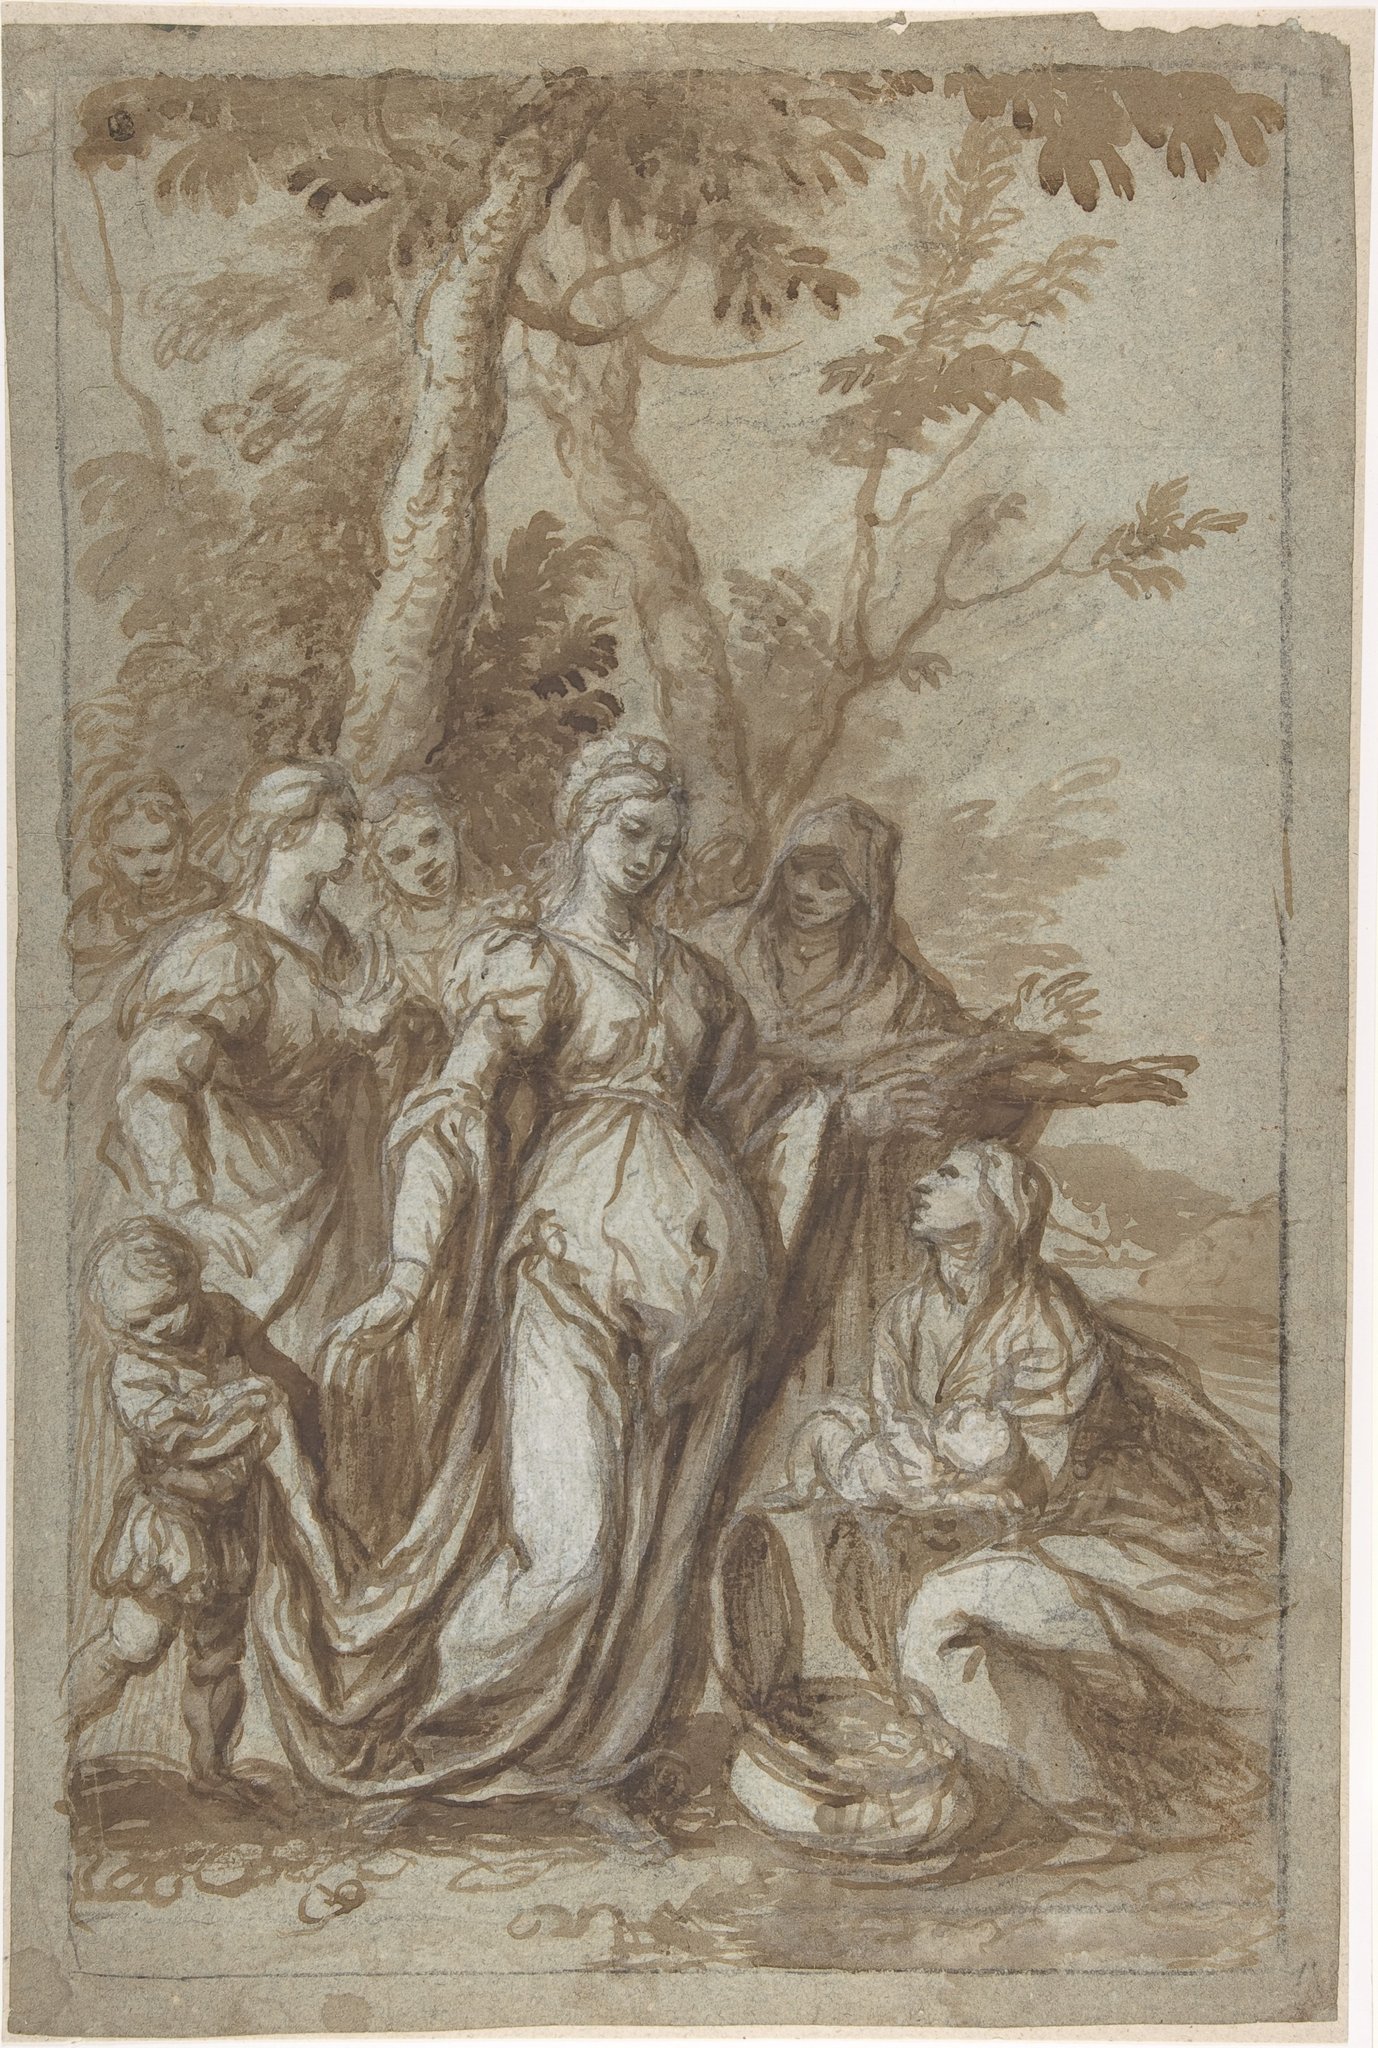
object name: drawing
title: The Finding of Moses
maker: montalto (giovanni stefano danedi or doneda)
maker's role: artist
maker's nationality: italian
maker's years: 1612-1690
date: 1671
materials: chalk, gouache, paper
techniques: brush, highlighting, wash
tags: women,trees,moses